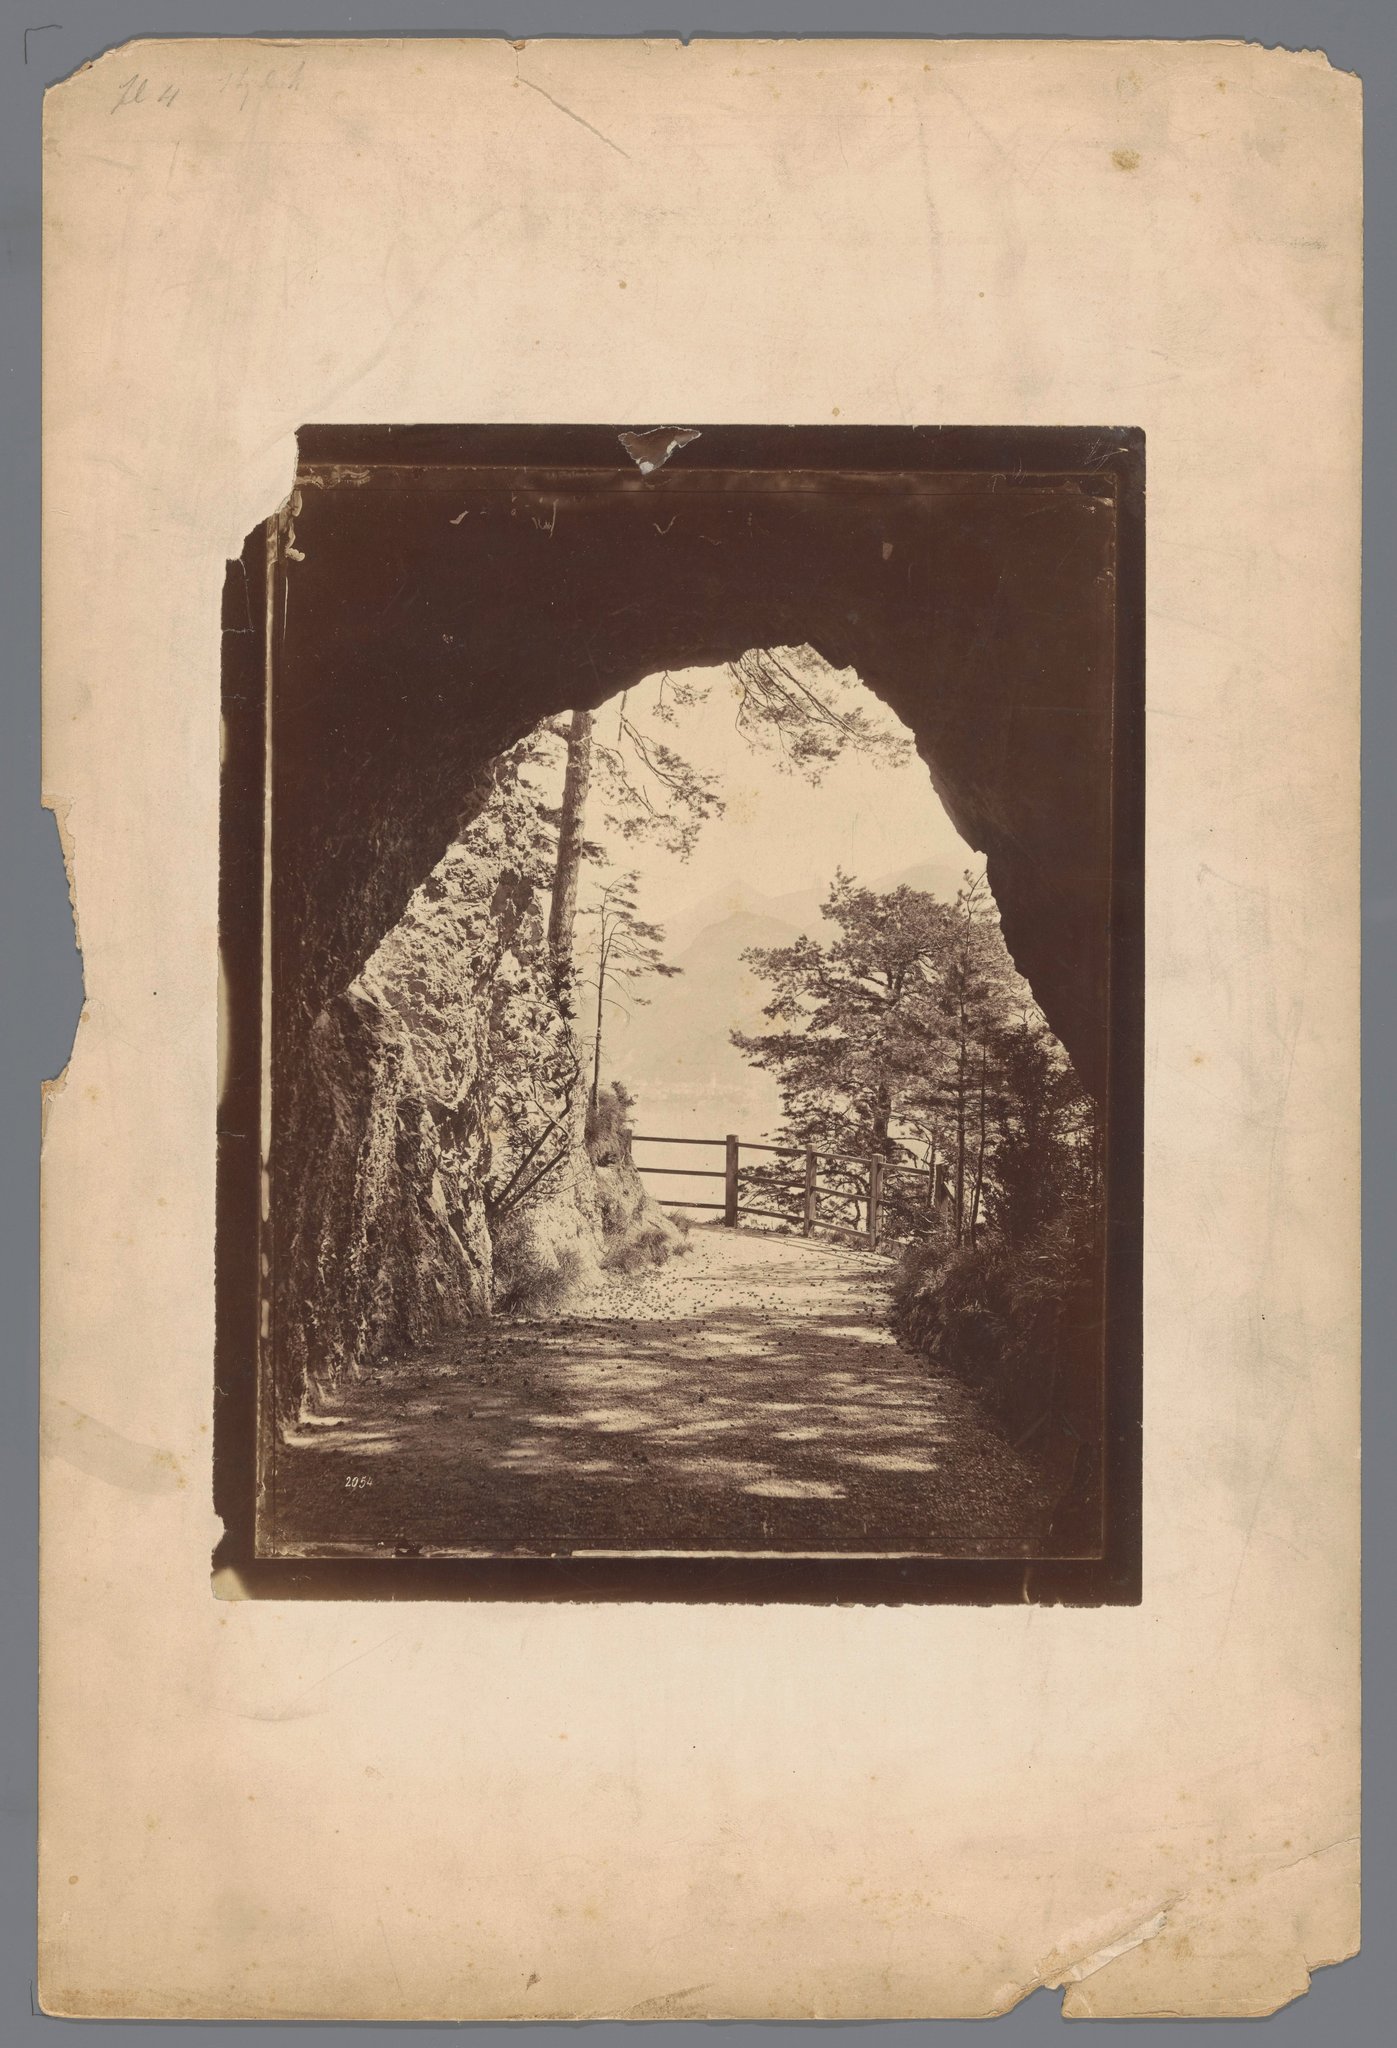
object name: photograph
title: Bergpad (vermoedelijk) te Italië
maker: gustave eugène chauffourier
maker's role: fotograaf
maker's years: 1845-1919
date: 1875-1900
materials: photographic support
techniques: albumen print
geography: italy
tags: road, path, mountains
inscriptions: number: ‘2054’, collector's mark: Lugt 3937, annotation: